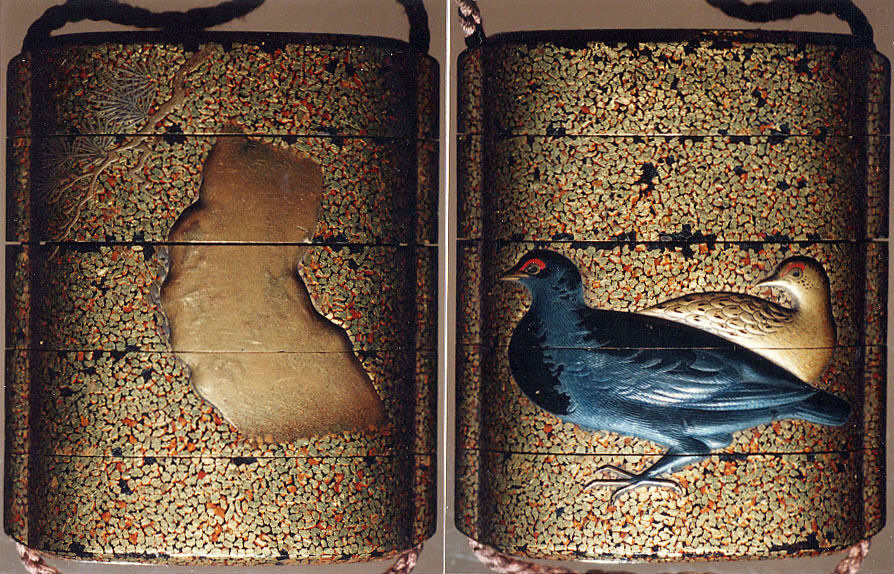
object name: inrō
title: Case (Inrō) with Design of Doves and Pine Branch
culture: japanese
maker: hakugyoku hogen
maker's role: artist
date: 1701-1900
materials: gold, lacquer, silver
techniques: fundame, hiramakie, maki-e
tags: doves